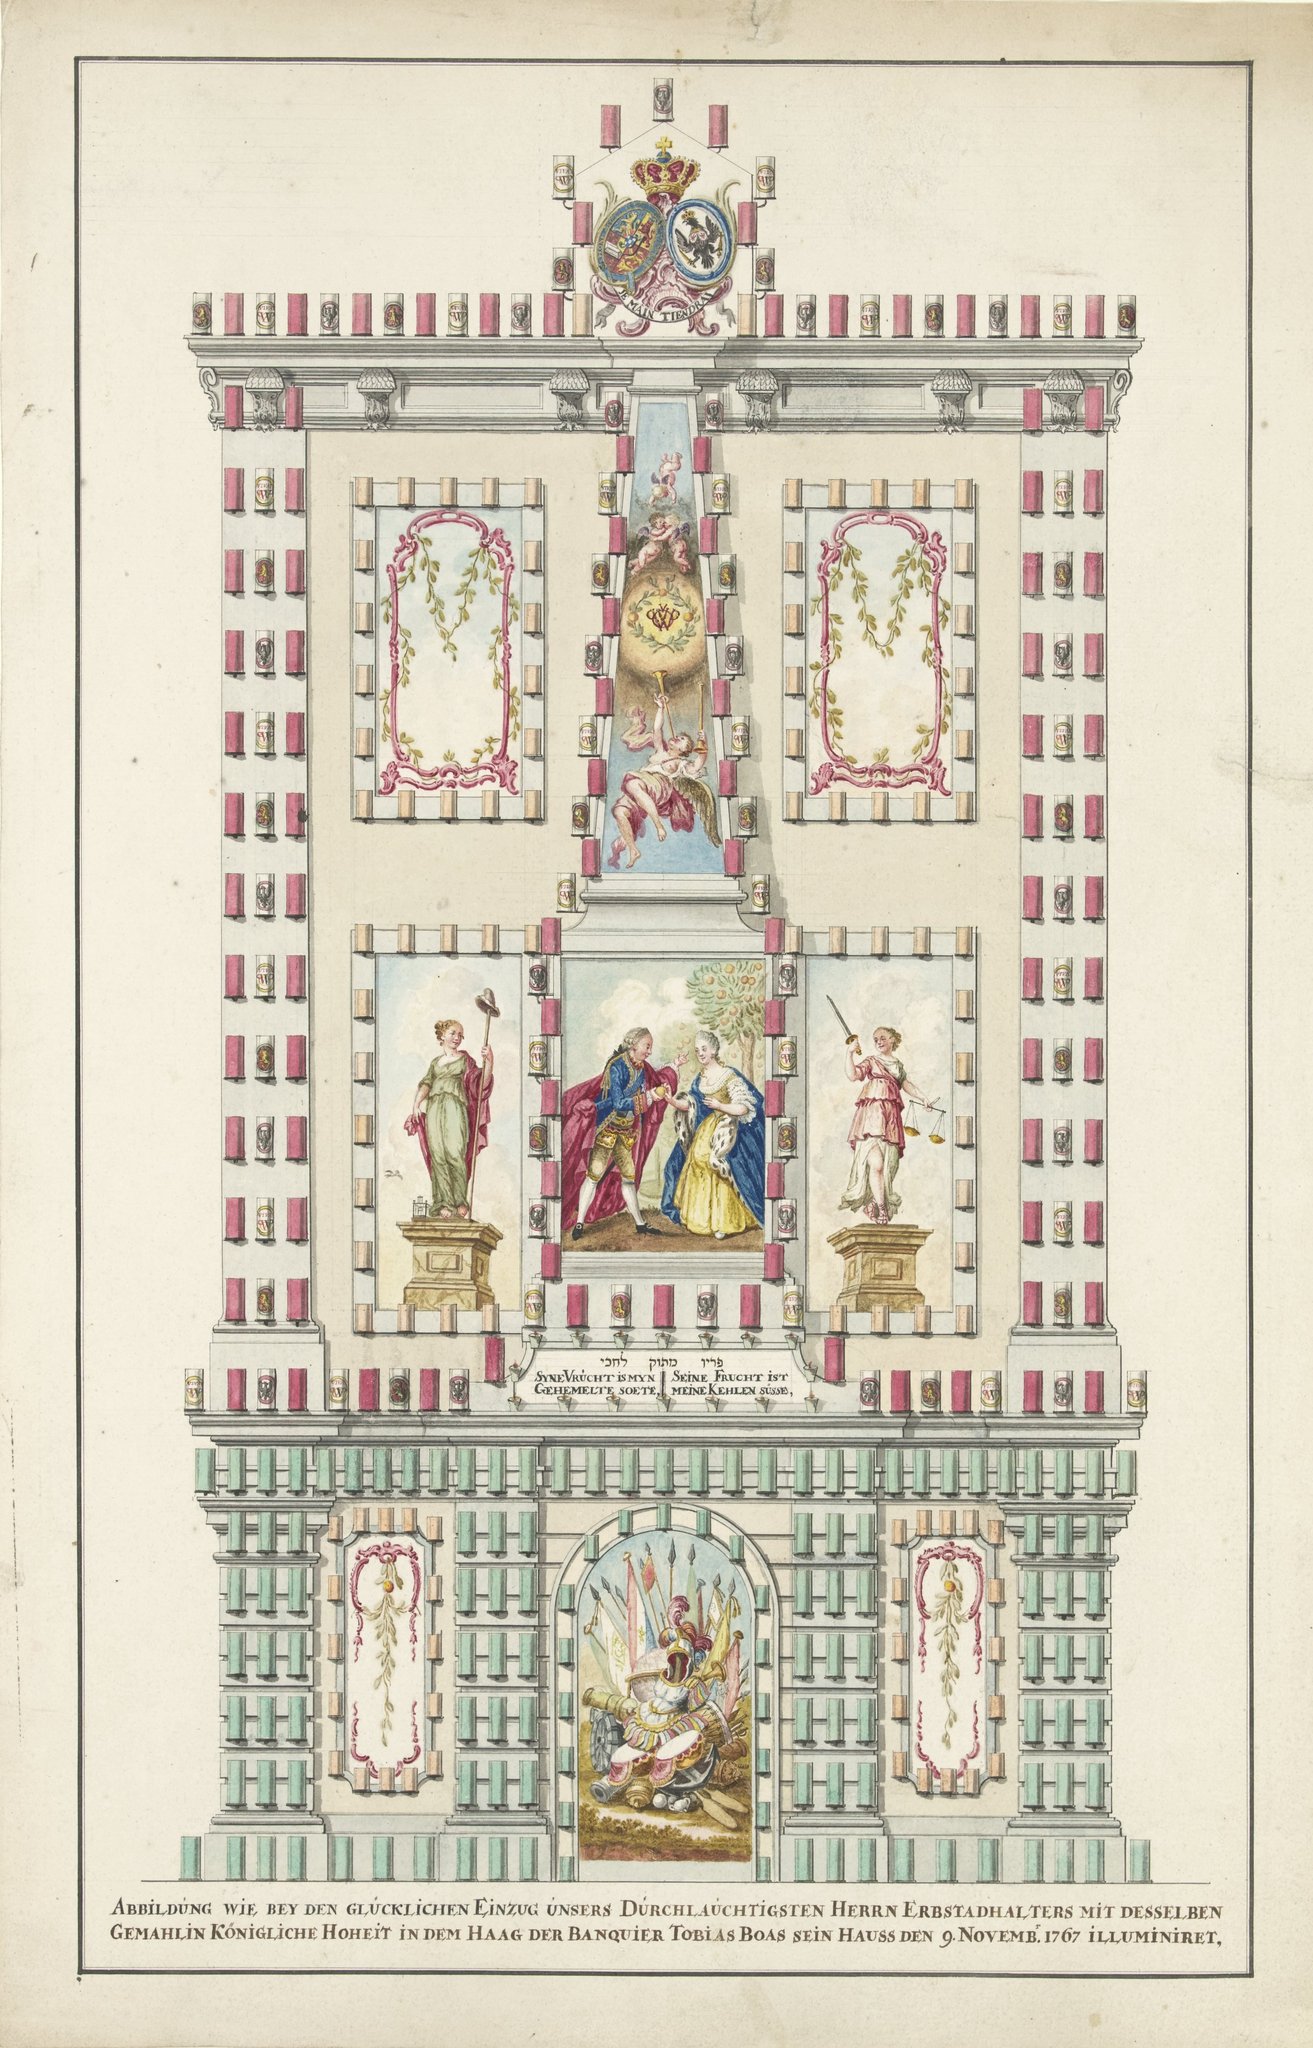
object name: drawing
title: Abbildung wie bey den glucklichen Einzug unsers Durchlauchtigsten Herrn Erbstadhalters mit desselben Gemahlin Königliche Hoheit in Dem Haag der Banquier Tobias Boas sein Hauss den 9. Novembr. 1767 illuminiret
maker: Anonymous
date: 1767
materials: paper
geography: northern netherlands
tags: the hague, william v (prince of orange), berlin, painter, draughtsman, wilhelmina of prussia (princess of orange), triumphal arch (+ illumination, fire-works ~ festive activities)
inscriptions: collector's mark: Lugt 2228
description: Illuminatie van het huis van de joodse bankier Tobias Boas te Den Haag, ter gelegenheid van de intrede van de pas getrouwde stadhouder Willem V en zijn echtgenote prinses Wilhelmina van Pruisen te Den Haag op 9 november 1767. Gevel versierd met panelen met allegorische voorstellingen, wapens en lampions.